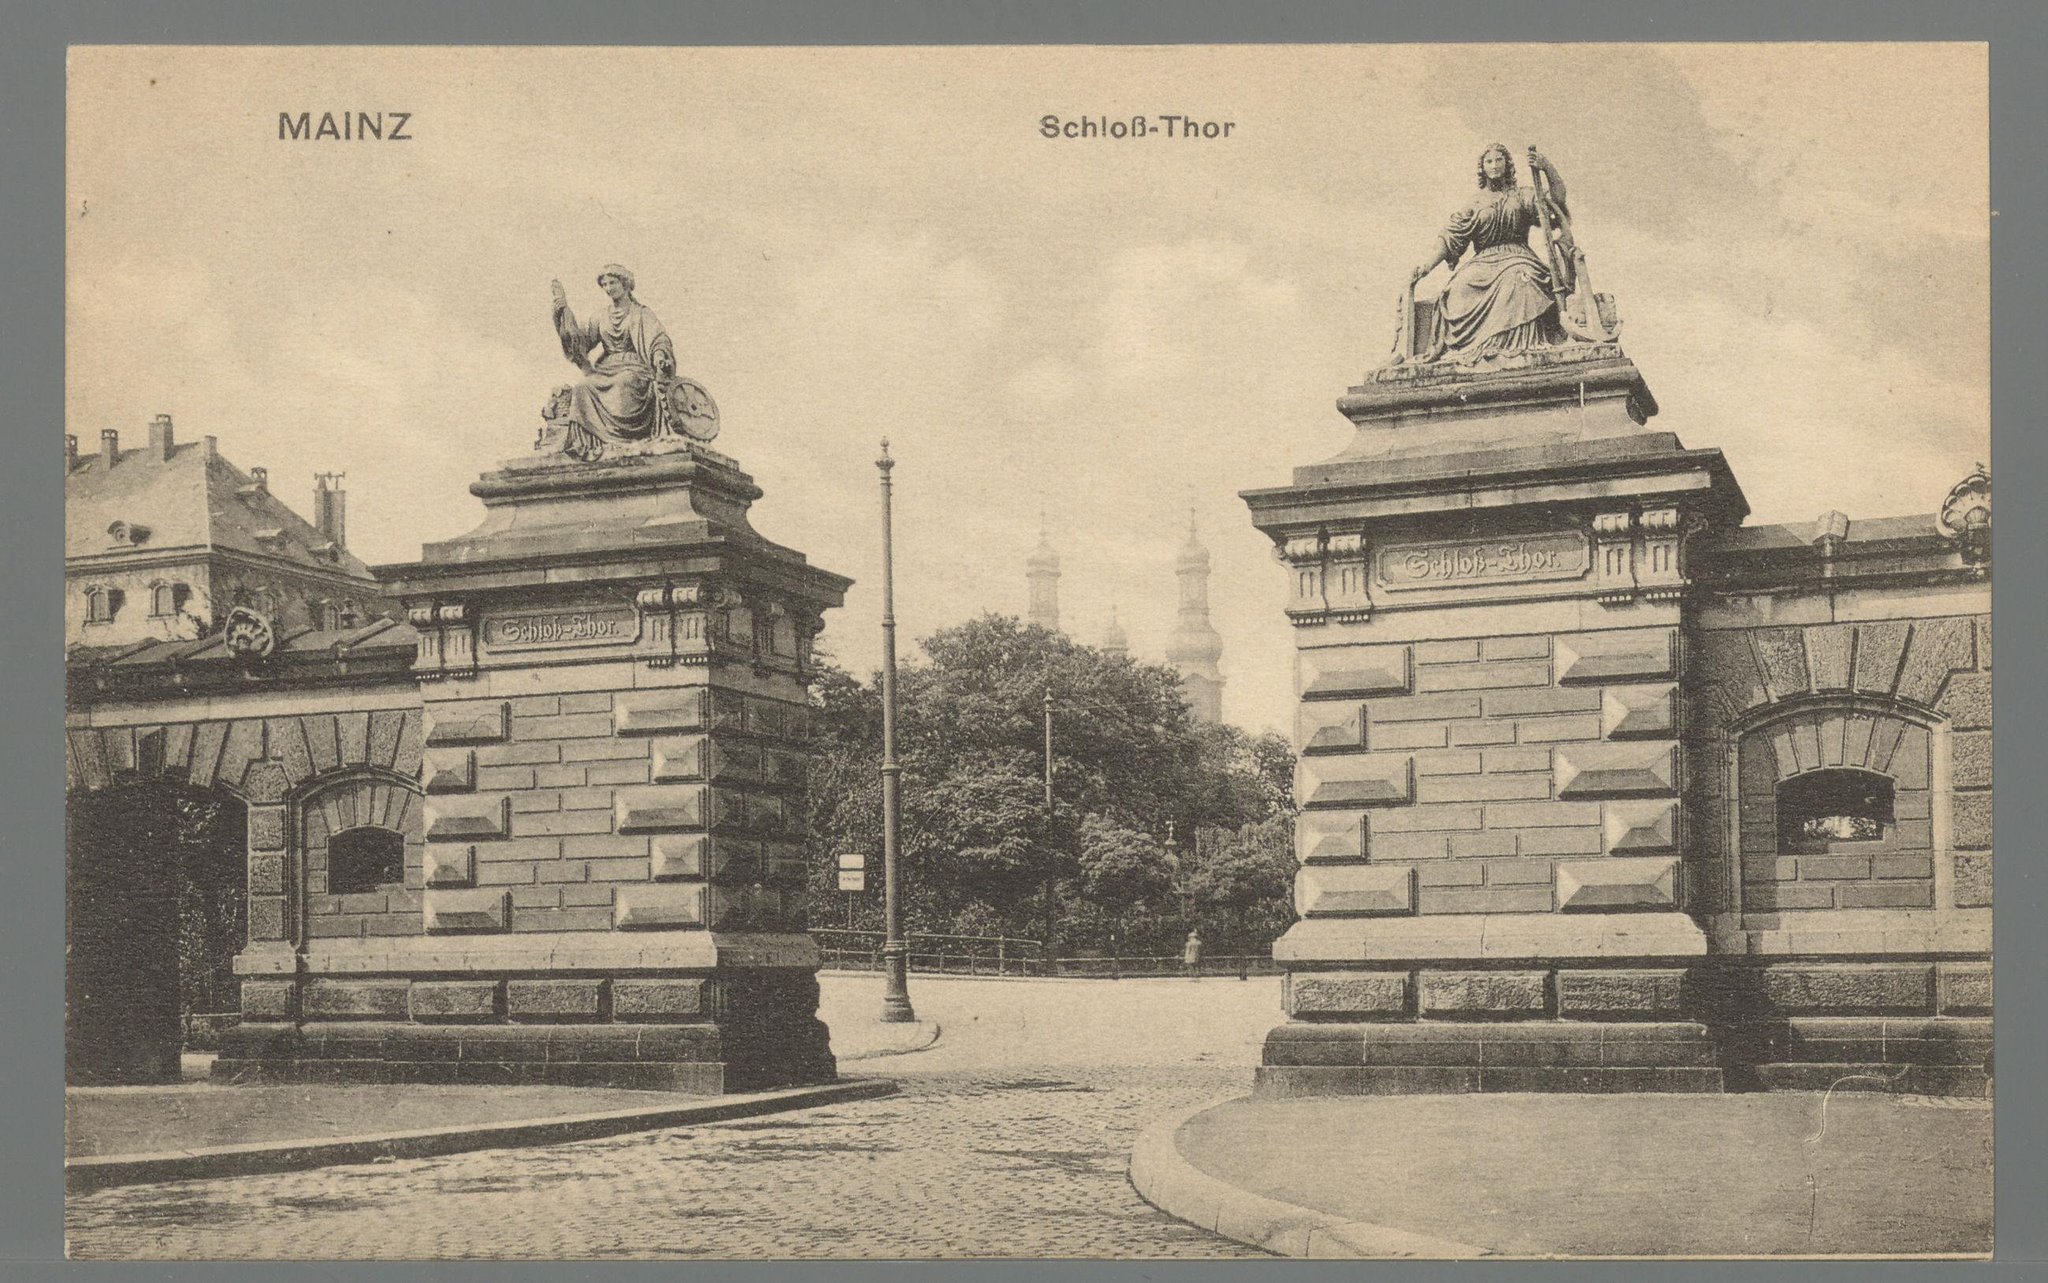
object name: photomechanical print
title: Mainz. Schloβ-Thor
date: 1905-1908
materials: cardboard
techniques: photograph, writing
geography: mainz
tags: castle, gate, entrance